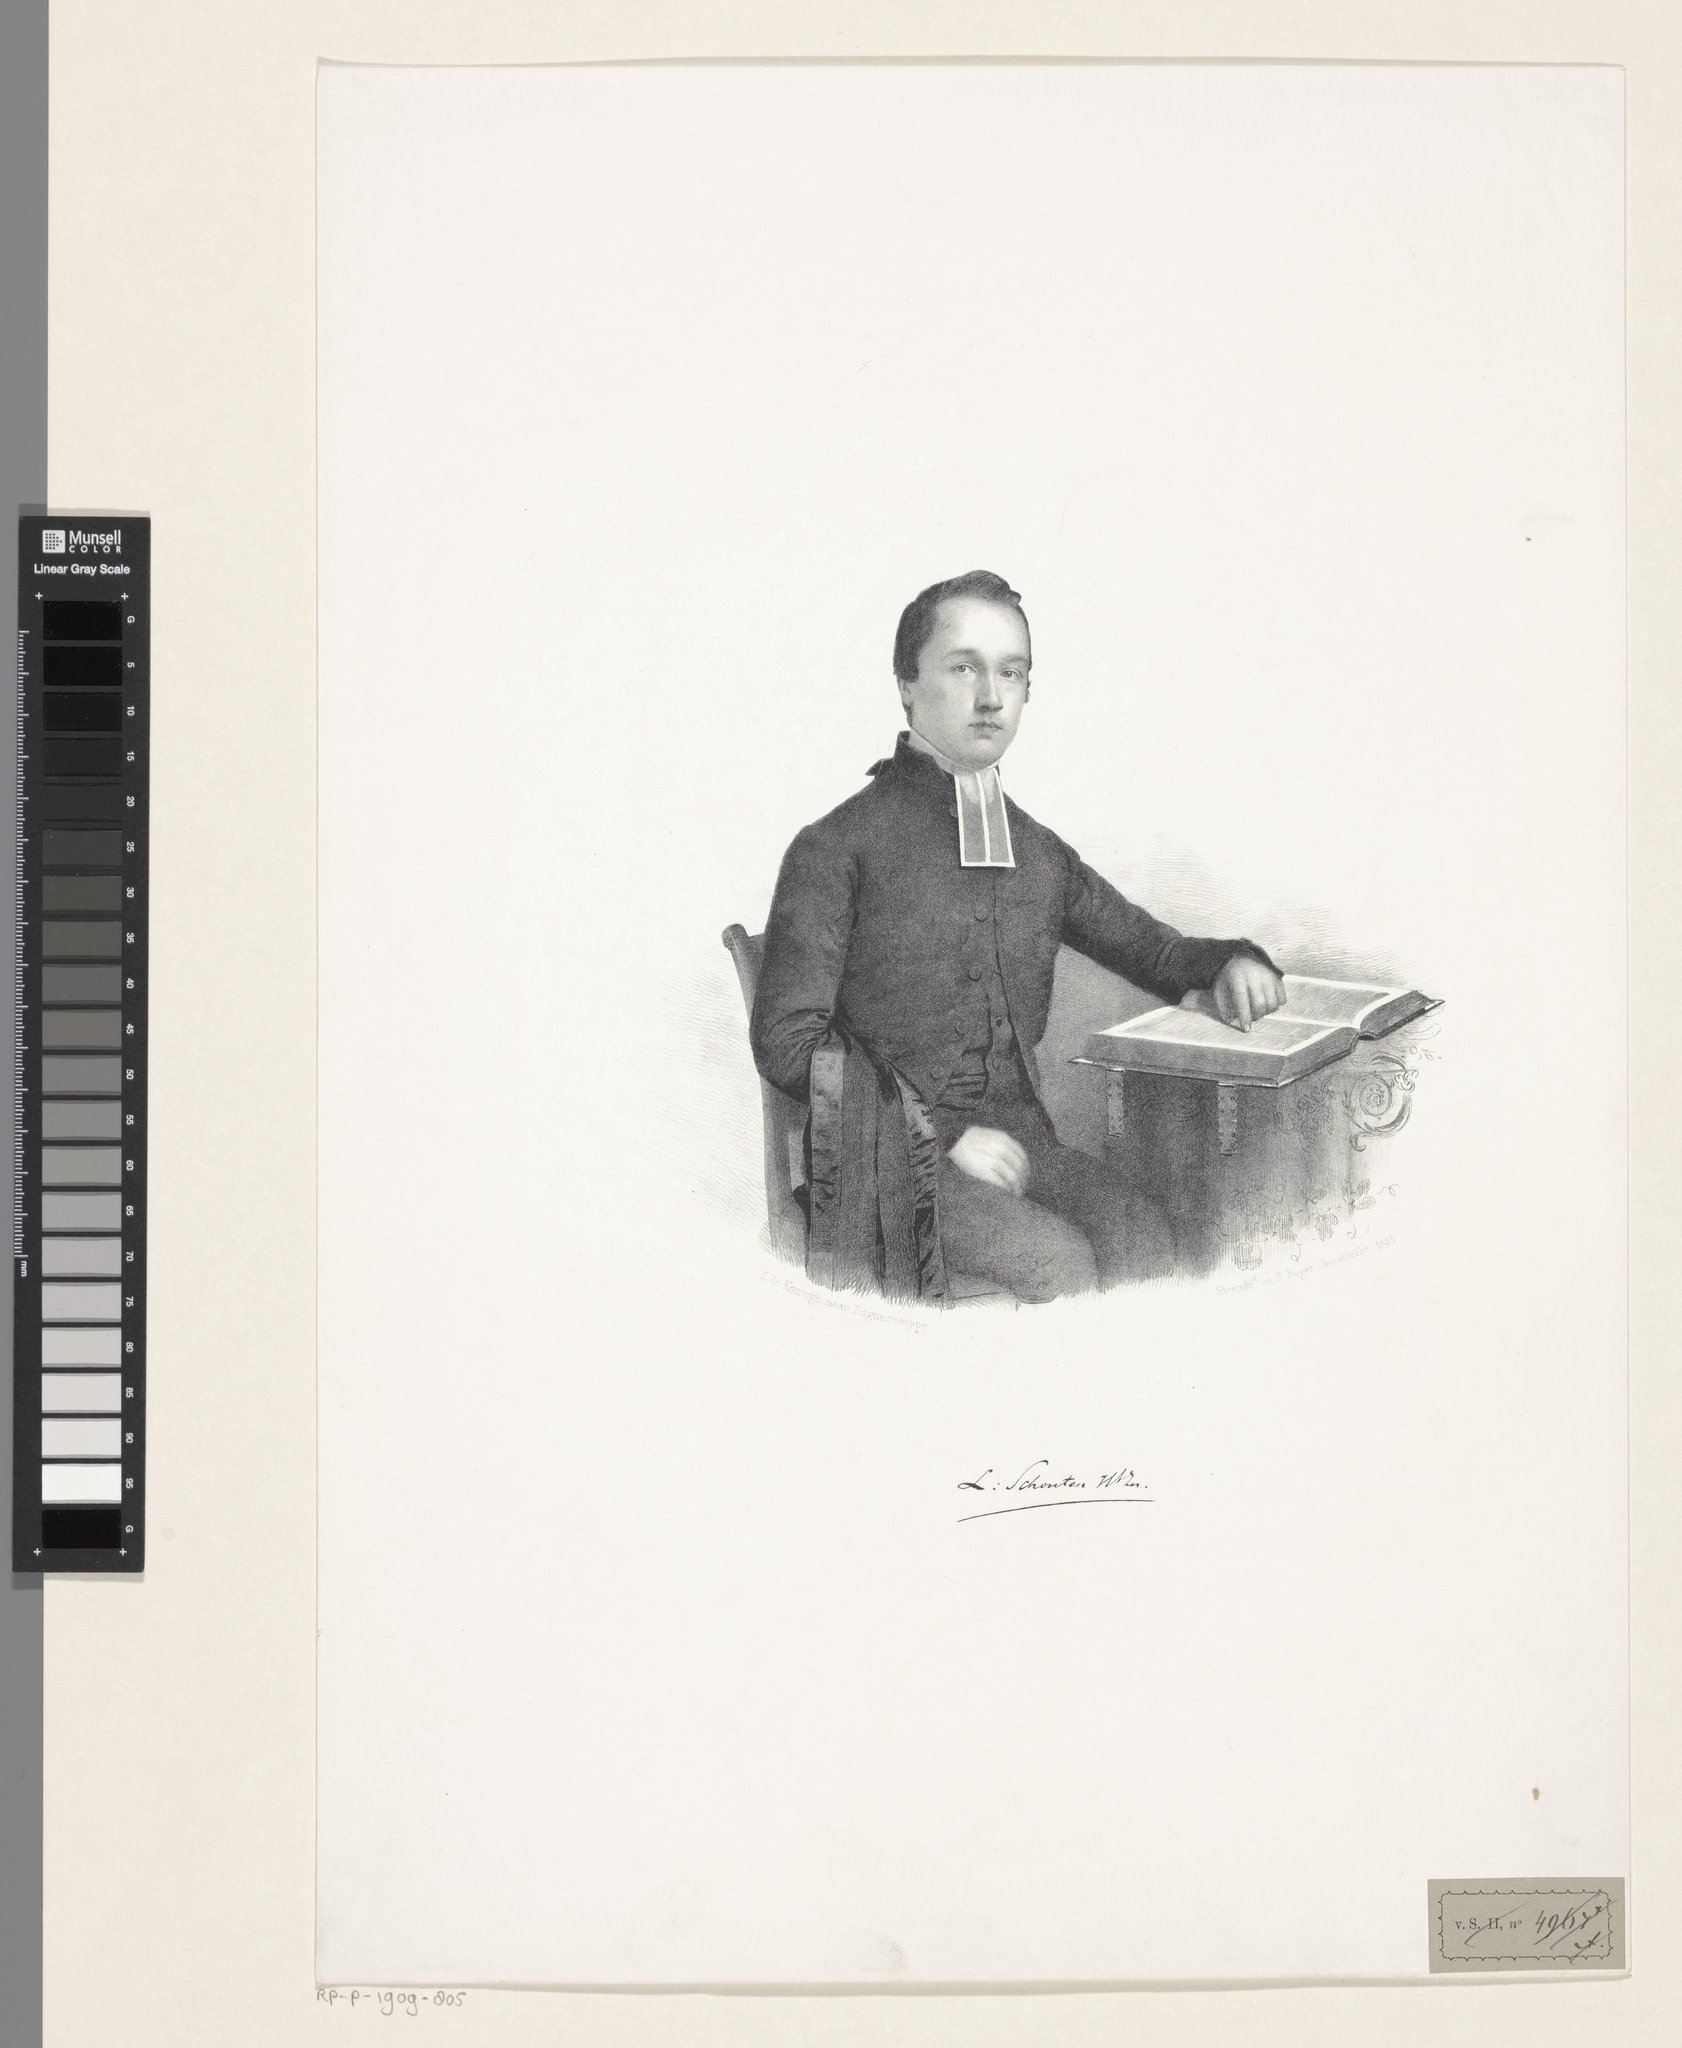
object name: print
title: Portret van L. Schouten Wzn.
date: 1855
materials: paper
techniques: lithograph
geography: dordrecht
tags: book - mm - book open, historical persons (+ three-quarter length portrait)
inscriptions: collector's mark: Lugt 2228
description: De geportretteerde wijst op een opengeslagen boek voor hem.